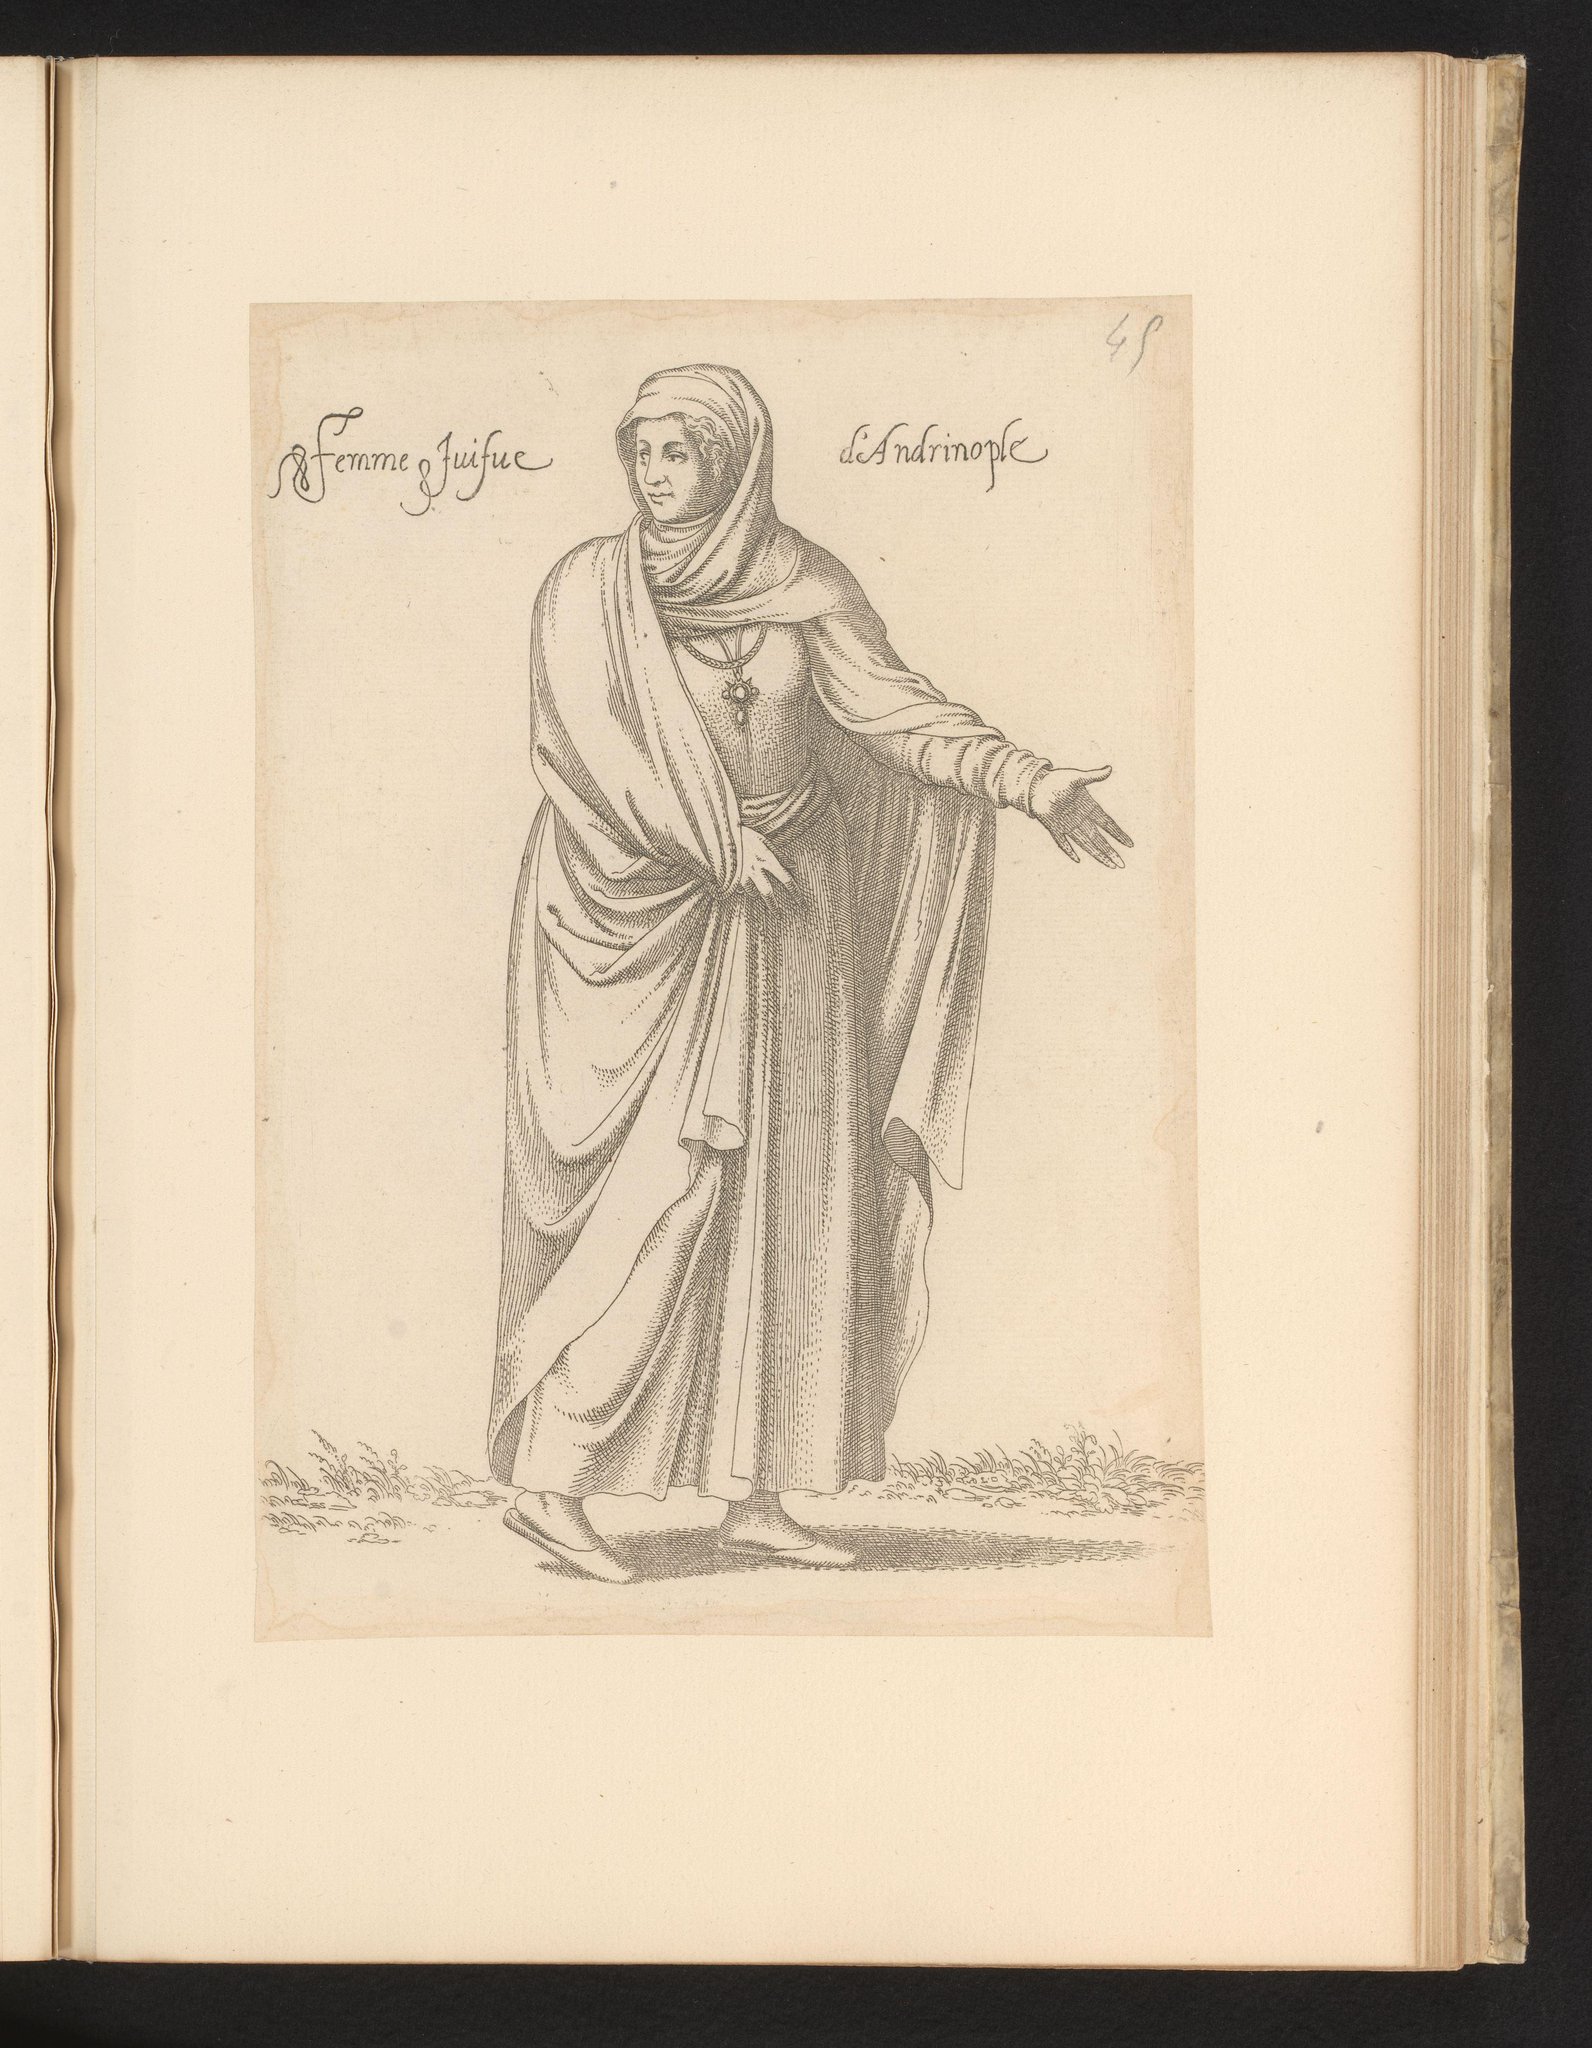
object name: album leaf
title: Joodse vrouw afkomstig uit Andrinopel of Edirne te Thracië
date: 1555-1568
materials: paper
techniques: etching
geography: lyon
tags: adult woman, europeans (greeks) (+ costume), folk costume, regional costume, the jews, jewish life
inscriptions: collector's mark: Lugt 2228, collector's mark: Lugt 2760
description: Prent uit: Nicolay, Nicolas de. Les quatre premiers livres des navigations et pérégrinations orientales, de N. de Nicolay, (...) Avec les figures au naturel tant d'hommes que de femmes selon la diversité des nations, & de leur port, maintien & habitz. Lyon: Guillaume (I) Rouille, 1568.